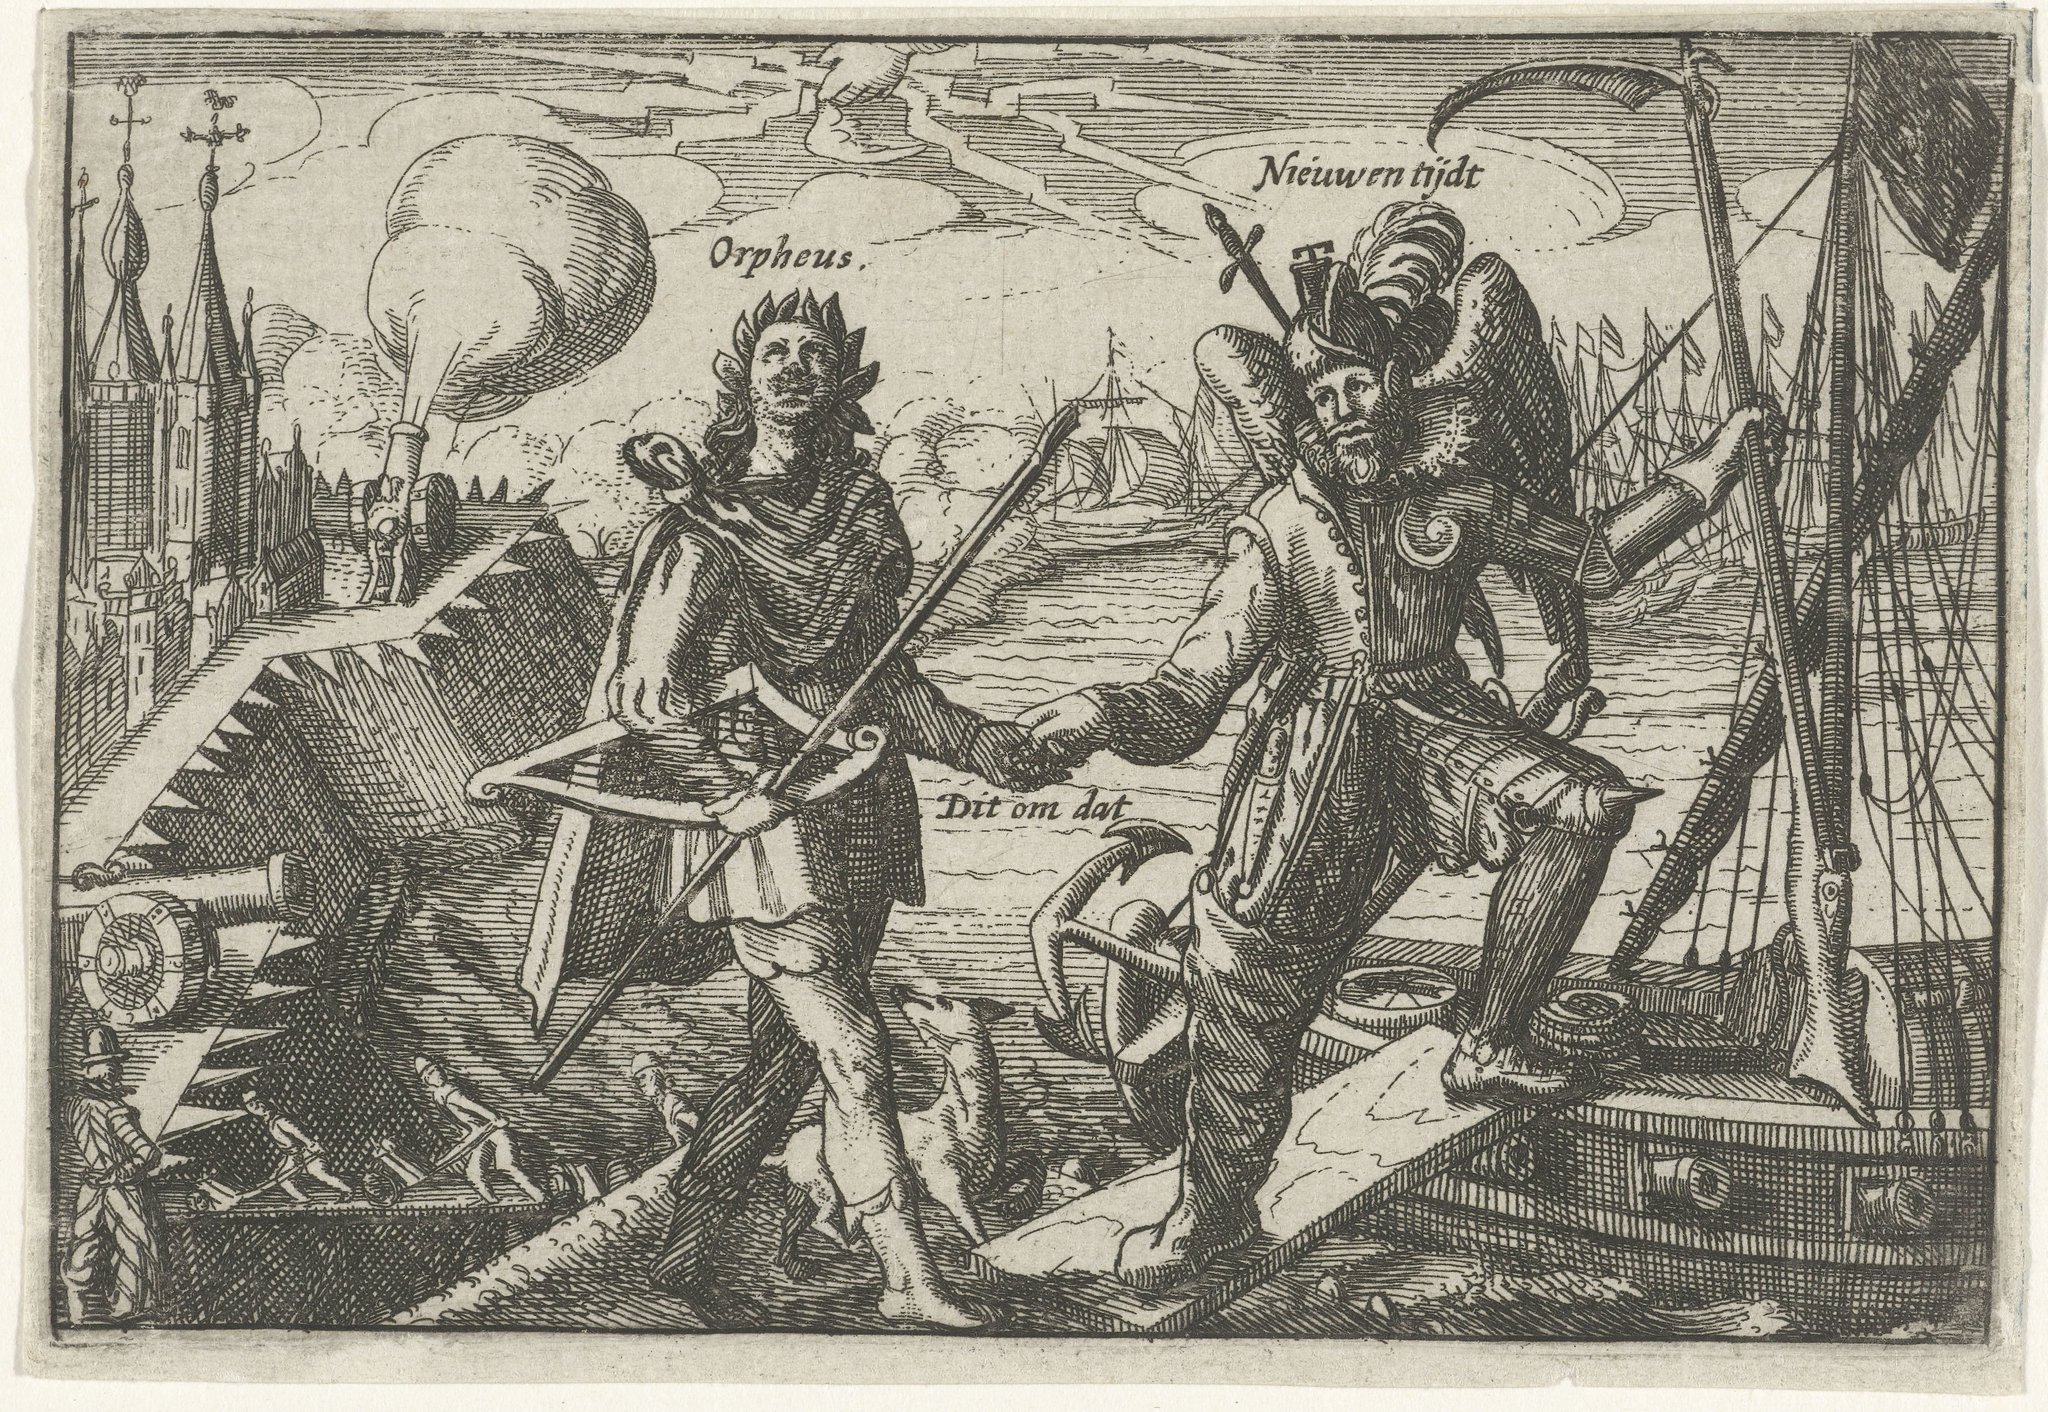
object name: print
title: Orpheus door Nieuwe Tijd aan boord genomen, 1625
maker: Anonymous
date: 1625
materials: paper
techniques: etching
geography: northern netherlands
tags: non-aggressive, friendly or neutral activities and relationships of orpheus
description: Politieke allegorie met Orpheus die door de Nieuwe Tijd aan boord van een schip wordt genomen. Links een stad met verdedigingsmuren en kanonnen. In de lucht een hand met bliksemstralen.